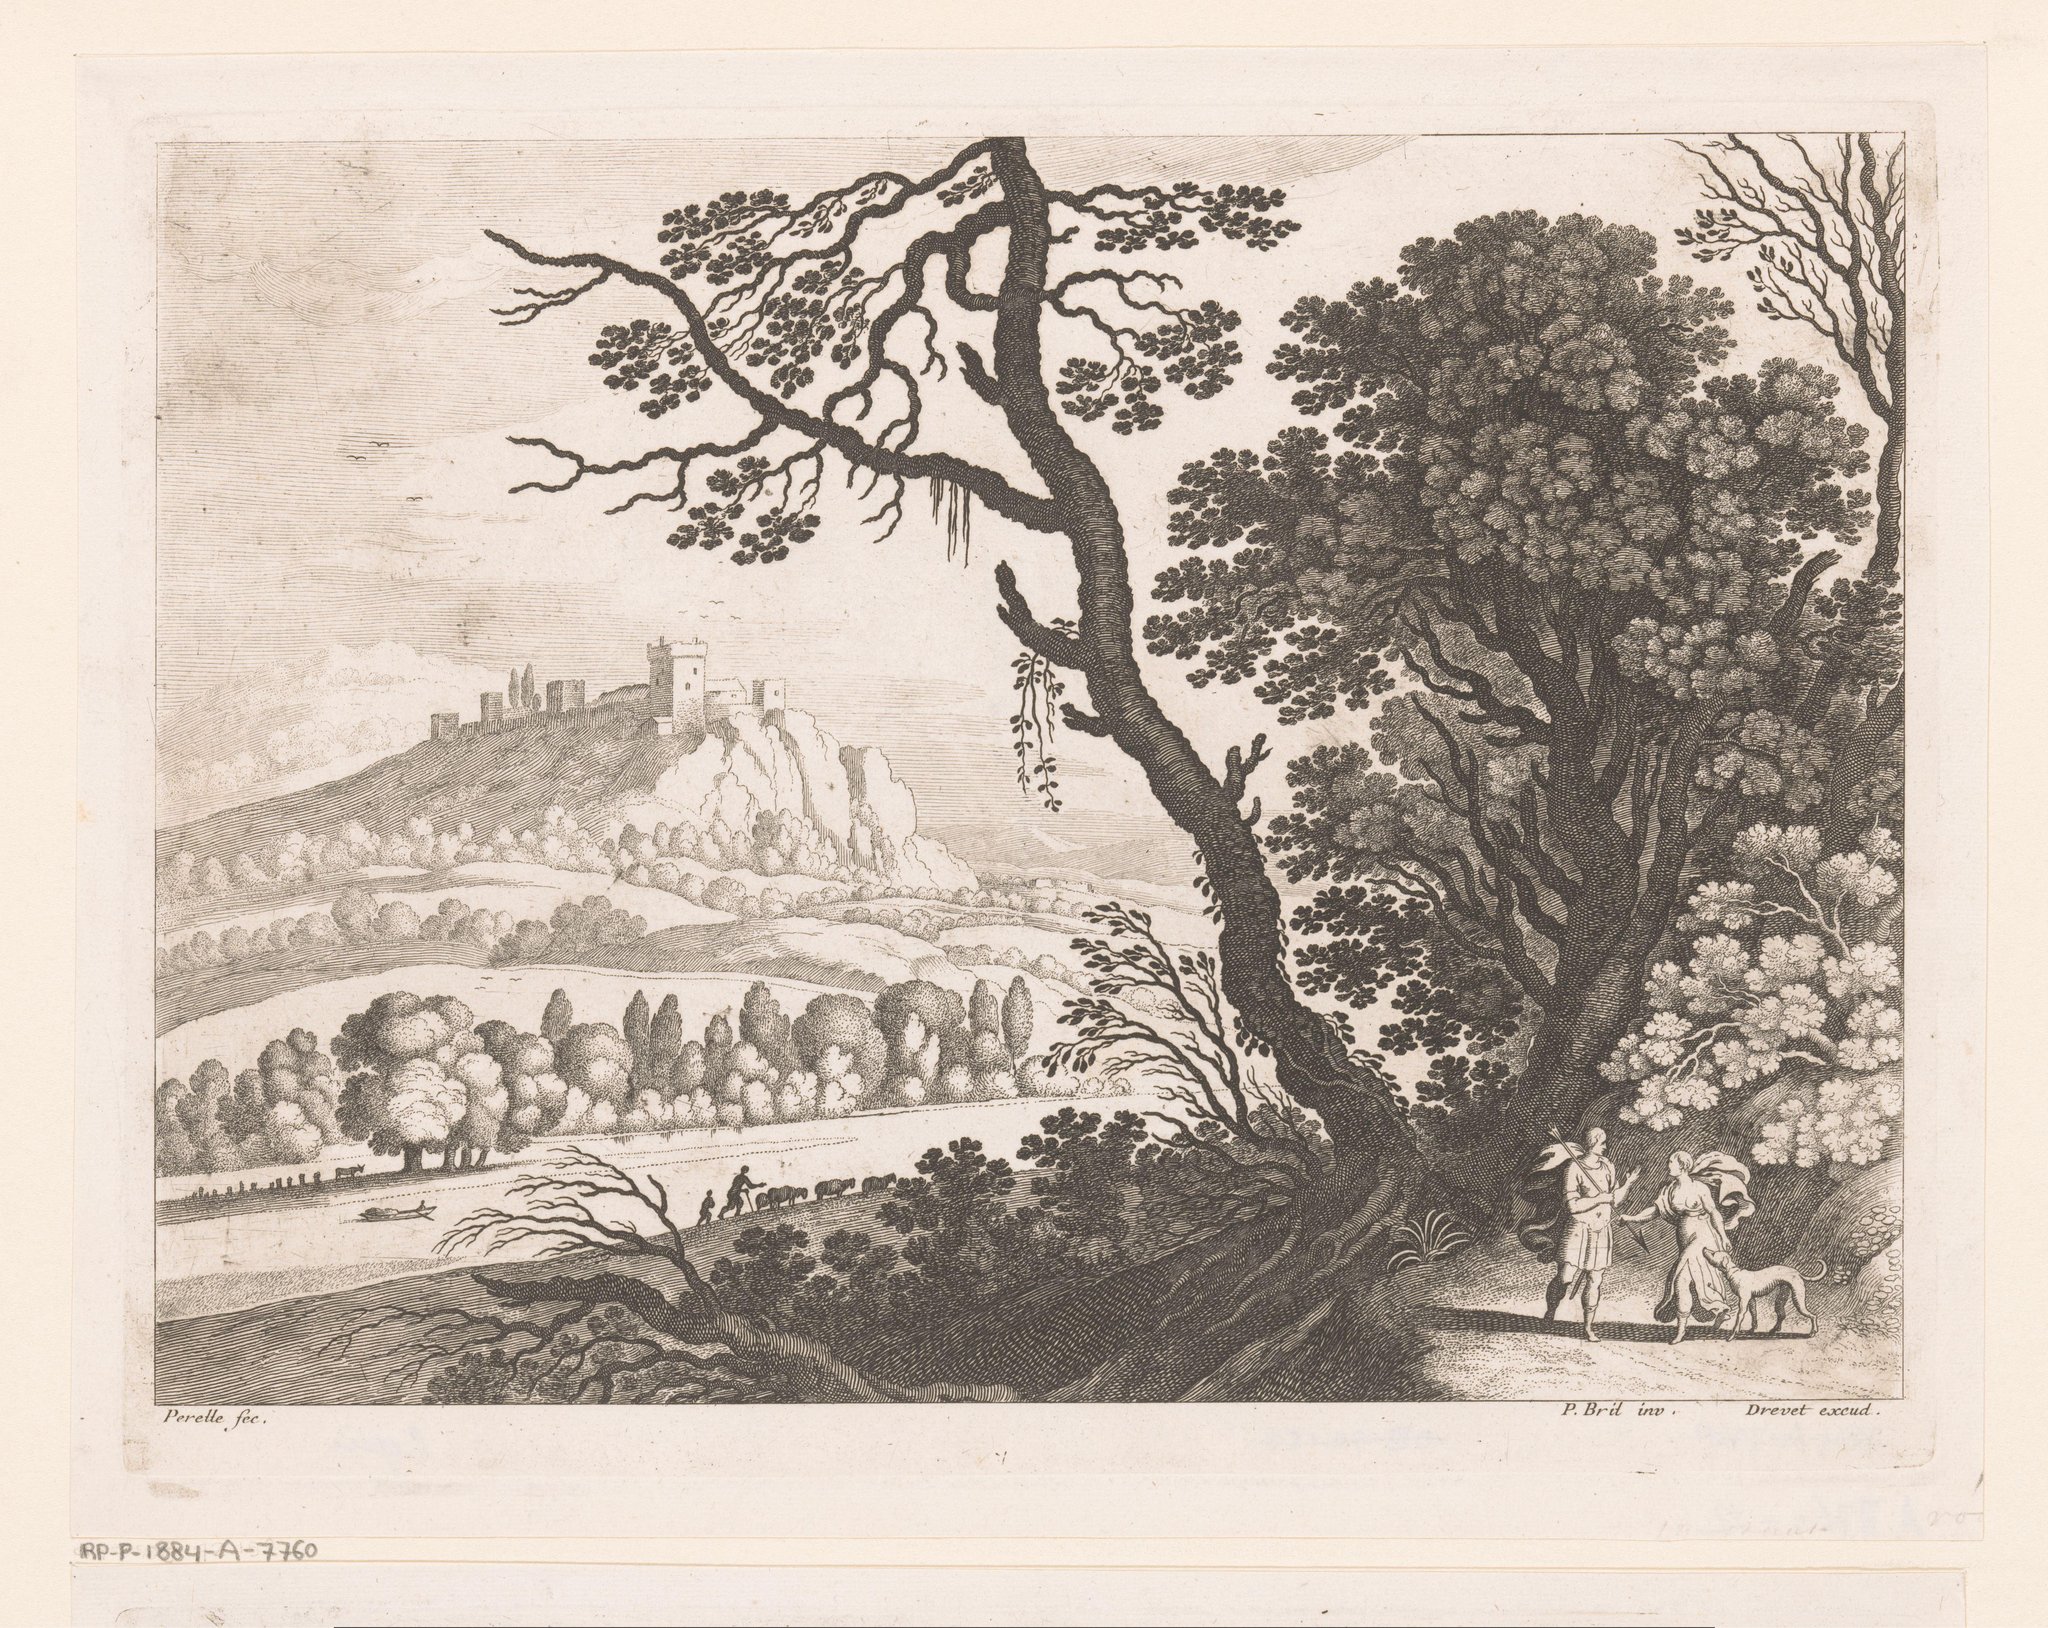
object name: print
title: Venus en Adonis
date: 1673-1695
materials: paper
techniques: etching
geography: paris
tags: landscapes with waters, waterscapes, seascapes (in the temperate zone), venus trying to prevent adonis from going hunting, dog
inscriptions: annotation: ‘Copie’, collector's mark: Lugt 2228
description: Prenten met het signatuur 'Perelle' kunnen zowel door vader Gabriel als door zonen Nicolas en Adam gemaakt zijn.